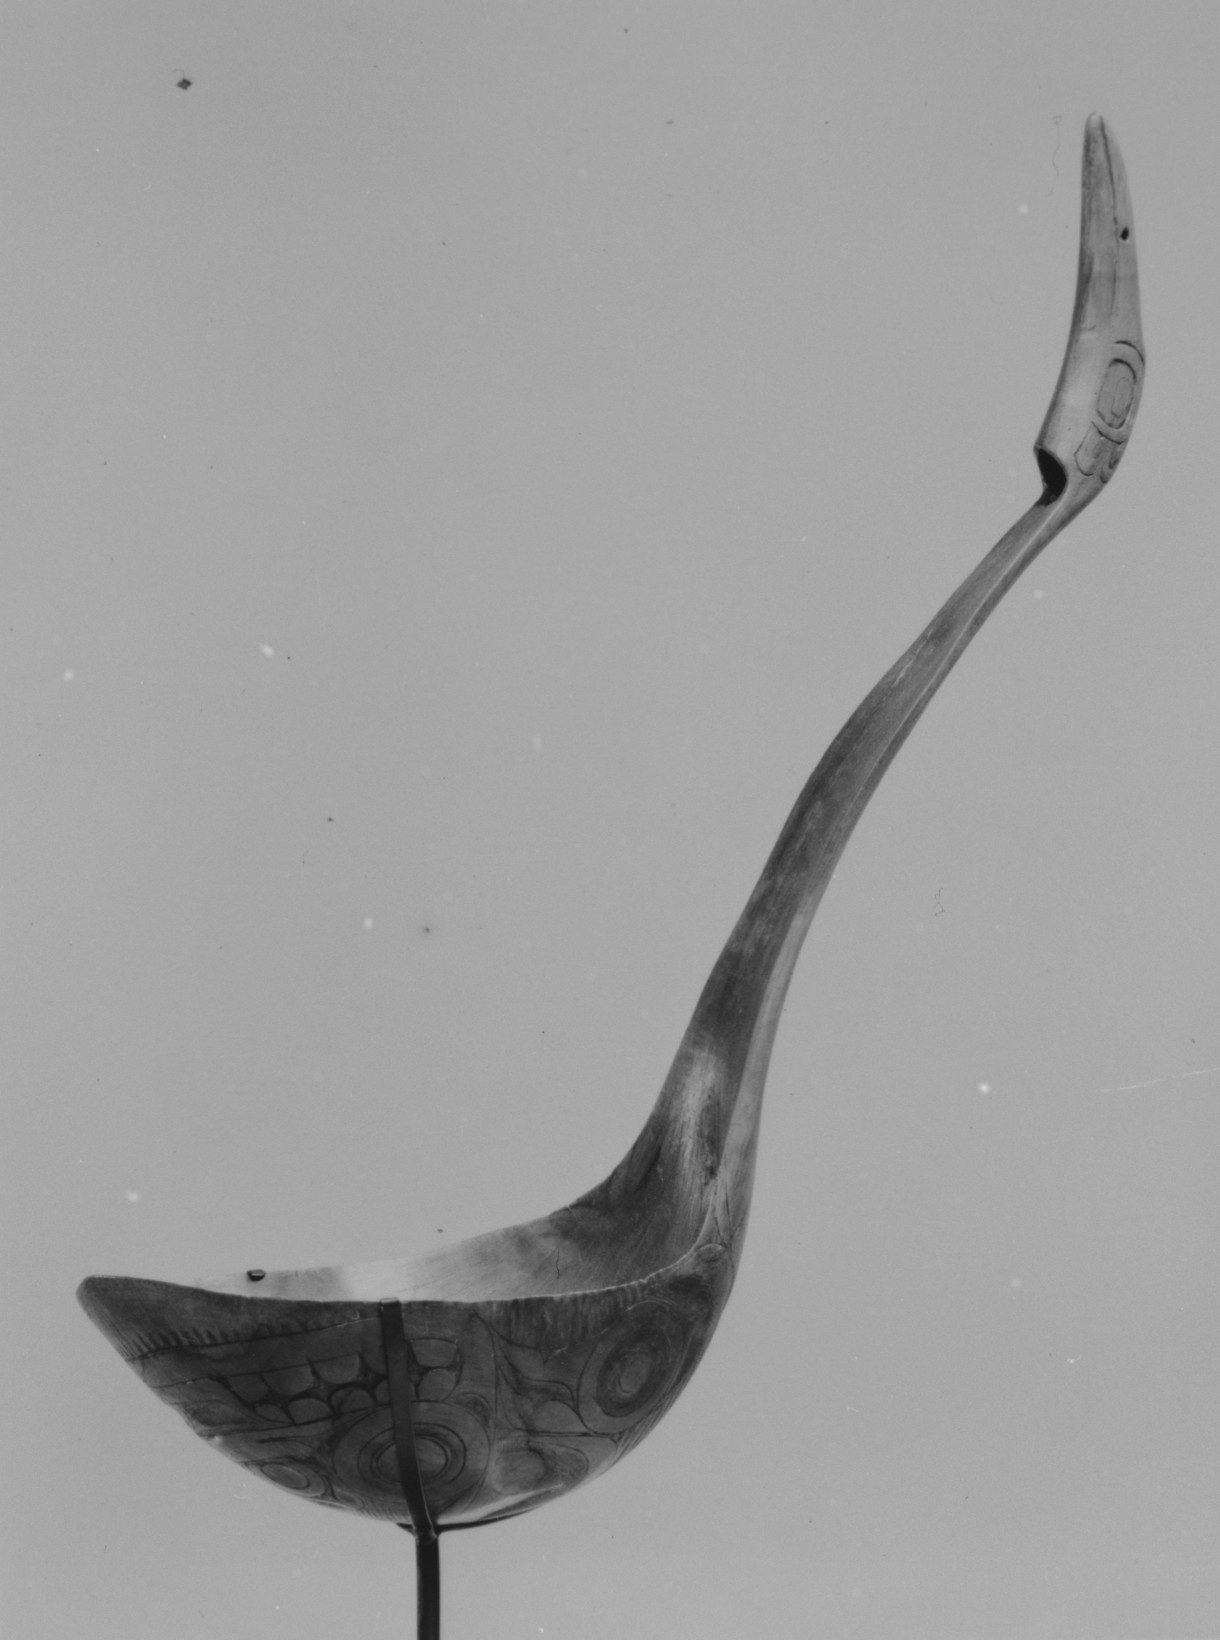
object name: ladle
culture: haida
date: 1850-1870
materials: horn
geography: canada